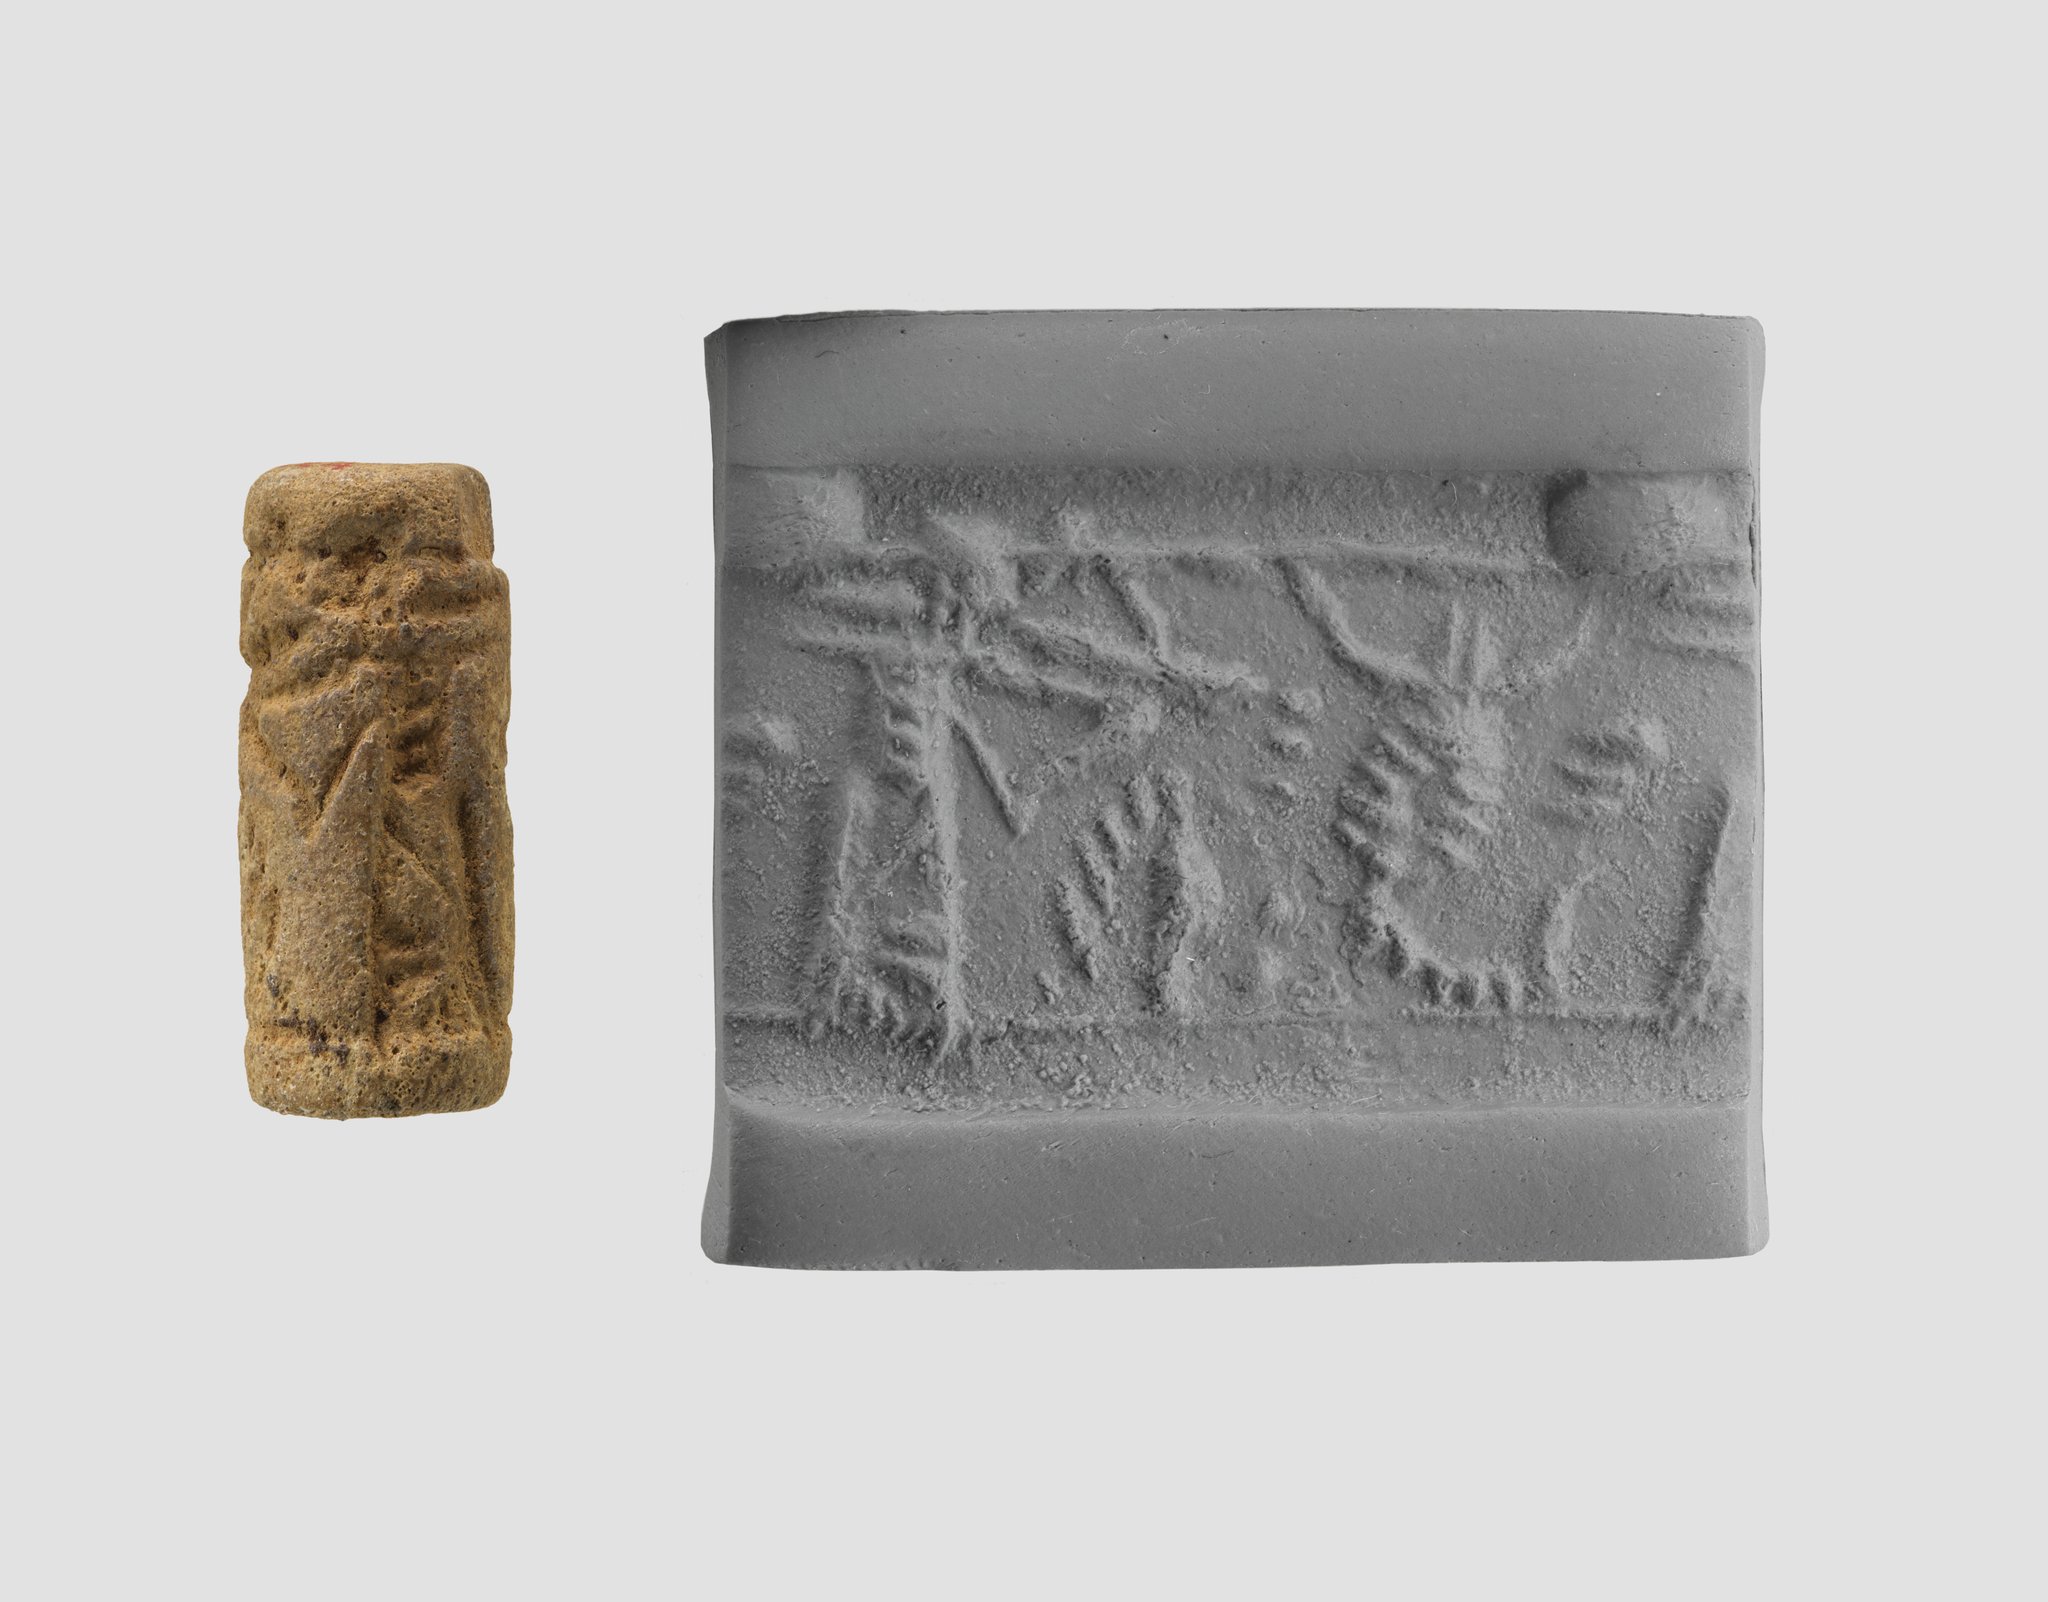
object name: cylinder seal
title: Cylinder seal with hunting scene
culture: assyrian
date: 834-668 BCE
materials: faience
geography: mesopotamia